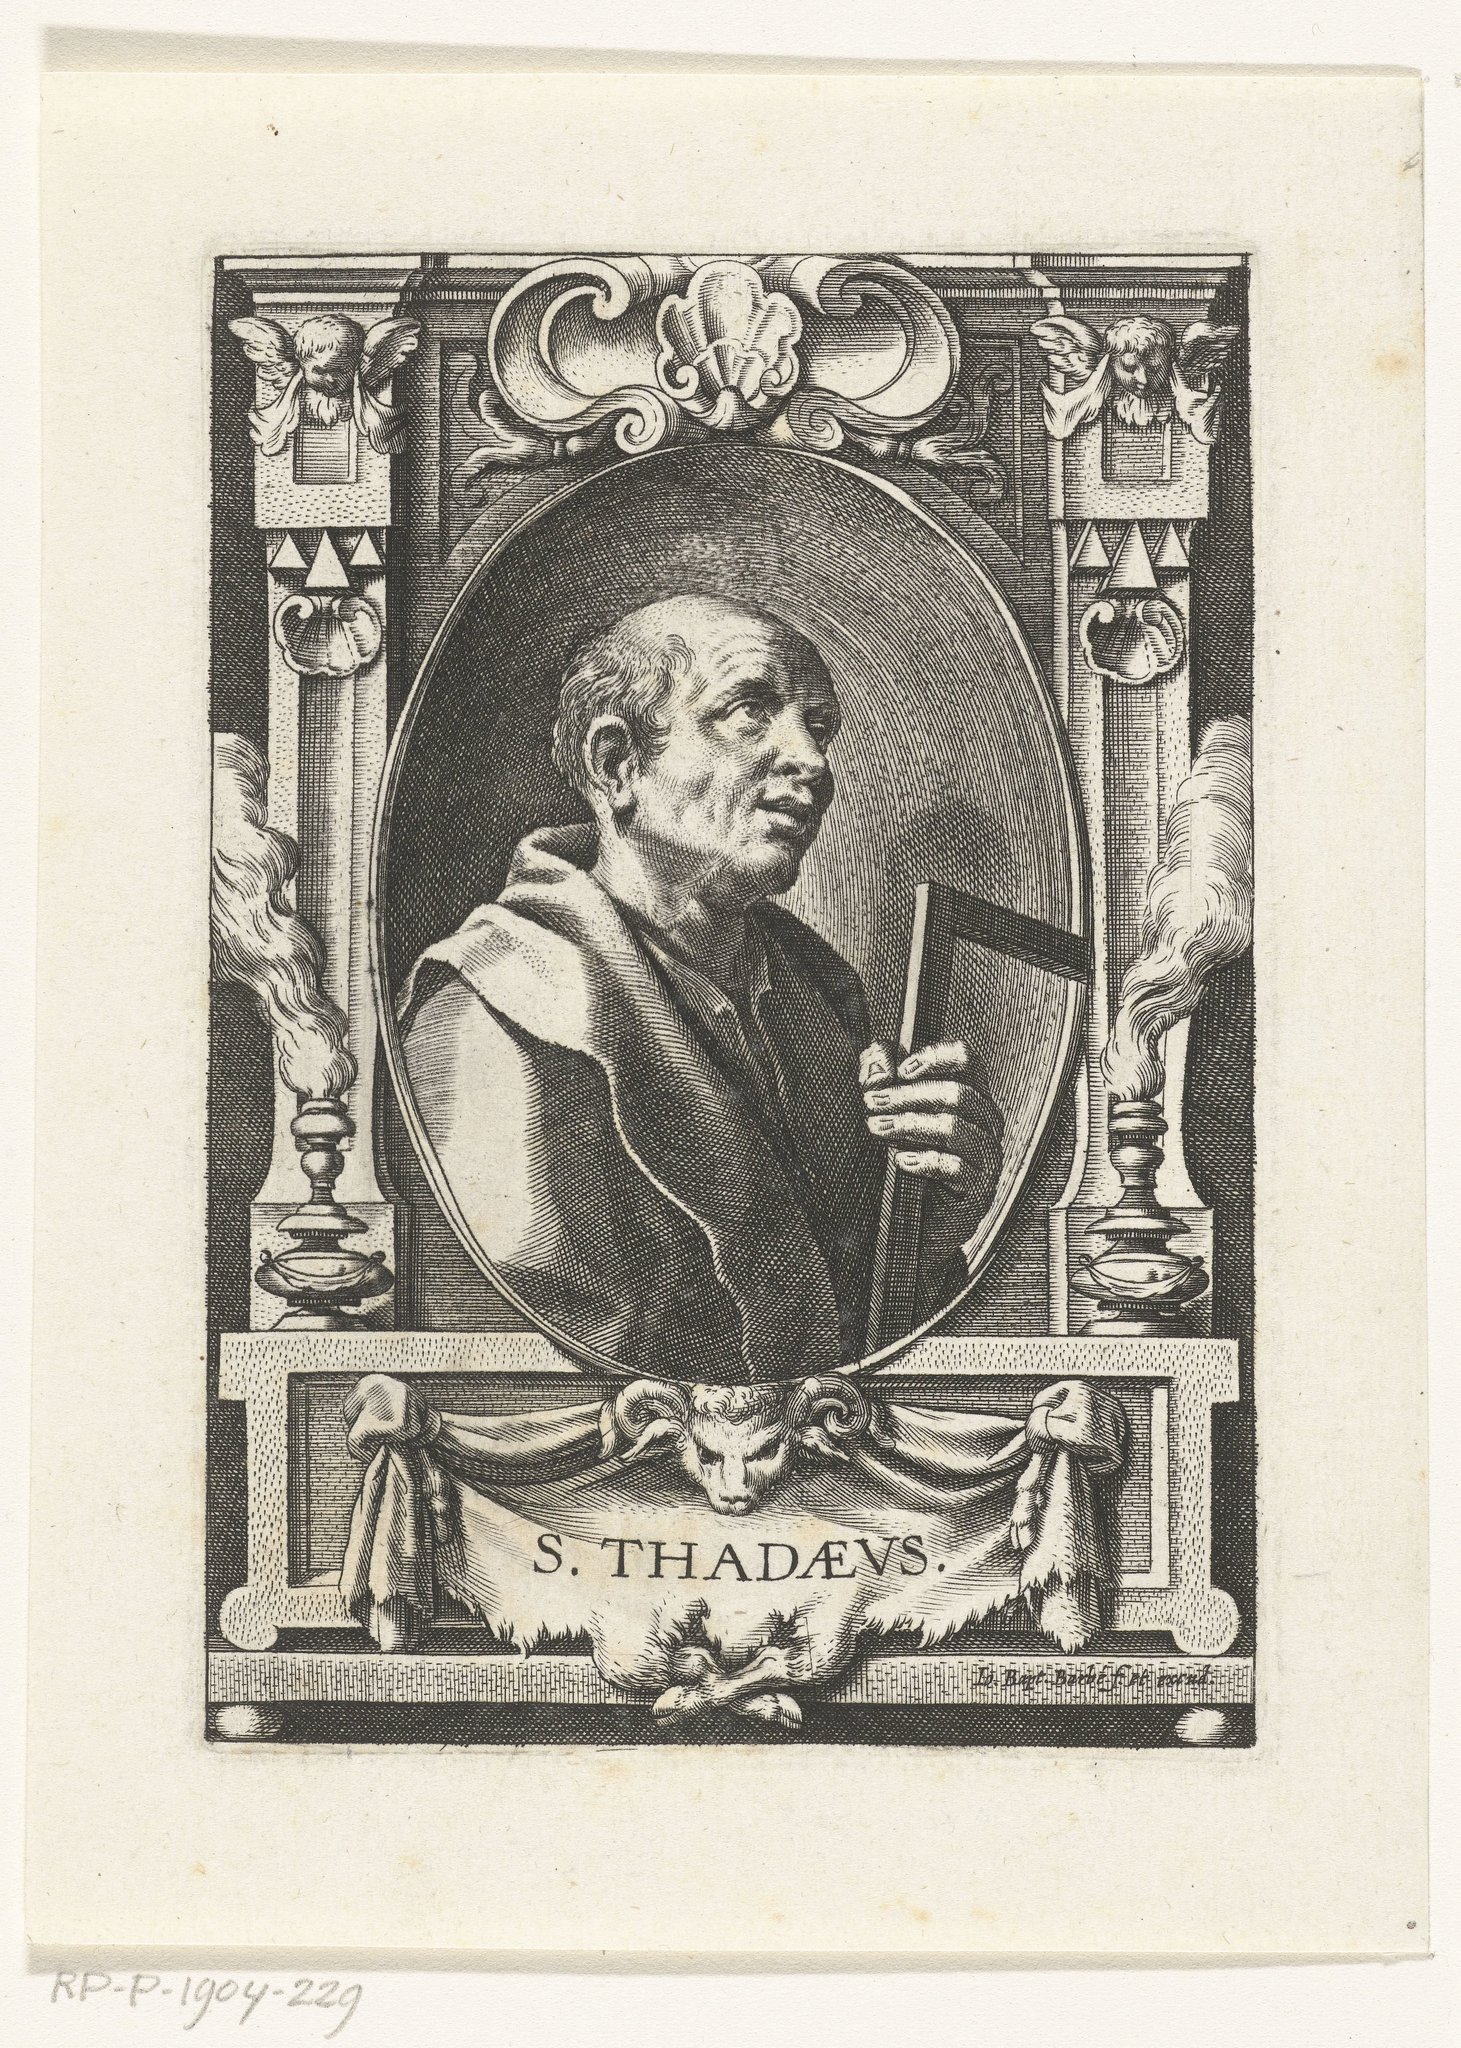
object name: print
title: Apostel Thomas met winkelhaak in omlijsting met architectuur ornamenten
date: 1588-1648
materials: paper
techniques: engraving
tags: the apostle thomas; possible attributes: book, chalice, girdle, heart, lance or spear, scroll, square, stones, ornament derived from architectural details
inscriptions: collector's mark: Lugt 2228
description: Het opschrift duidt deze apostel als de heilige Judas Taddeüs maar dit is op basis van het uiterlijk en zijn attribuut niet correct. De heilige Thomas wordt vaak als jonge man met het gereedschap van een bouwmeester, in dit geval een winkelhaak, afgebeeld.